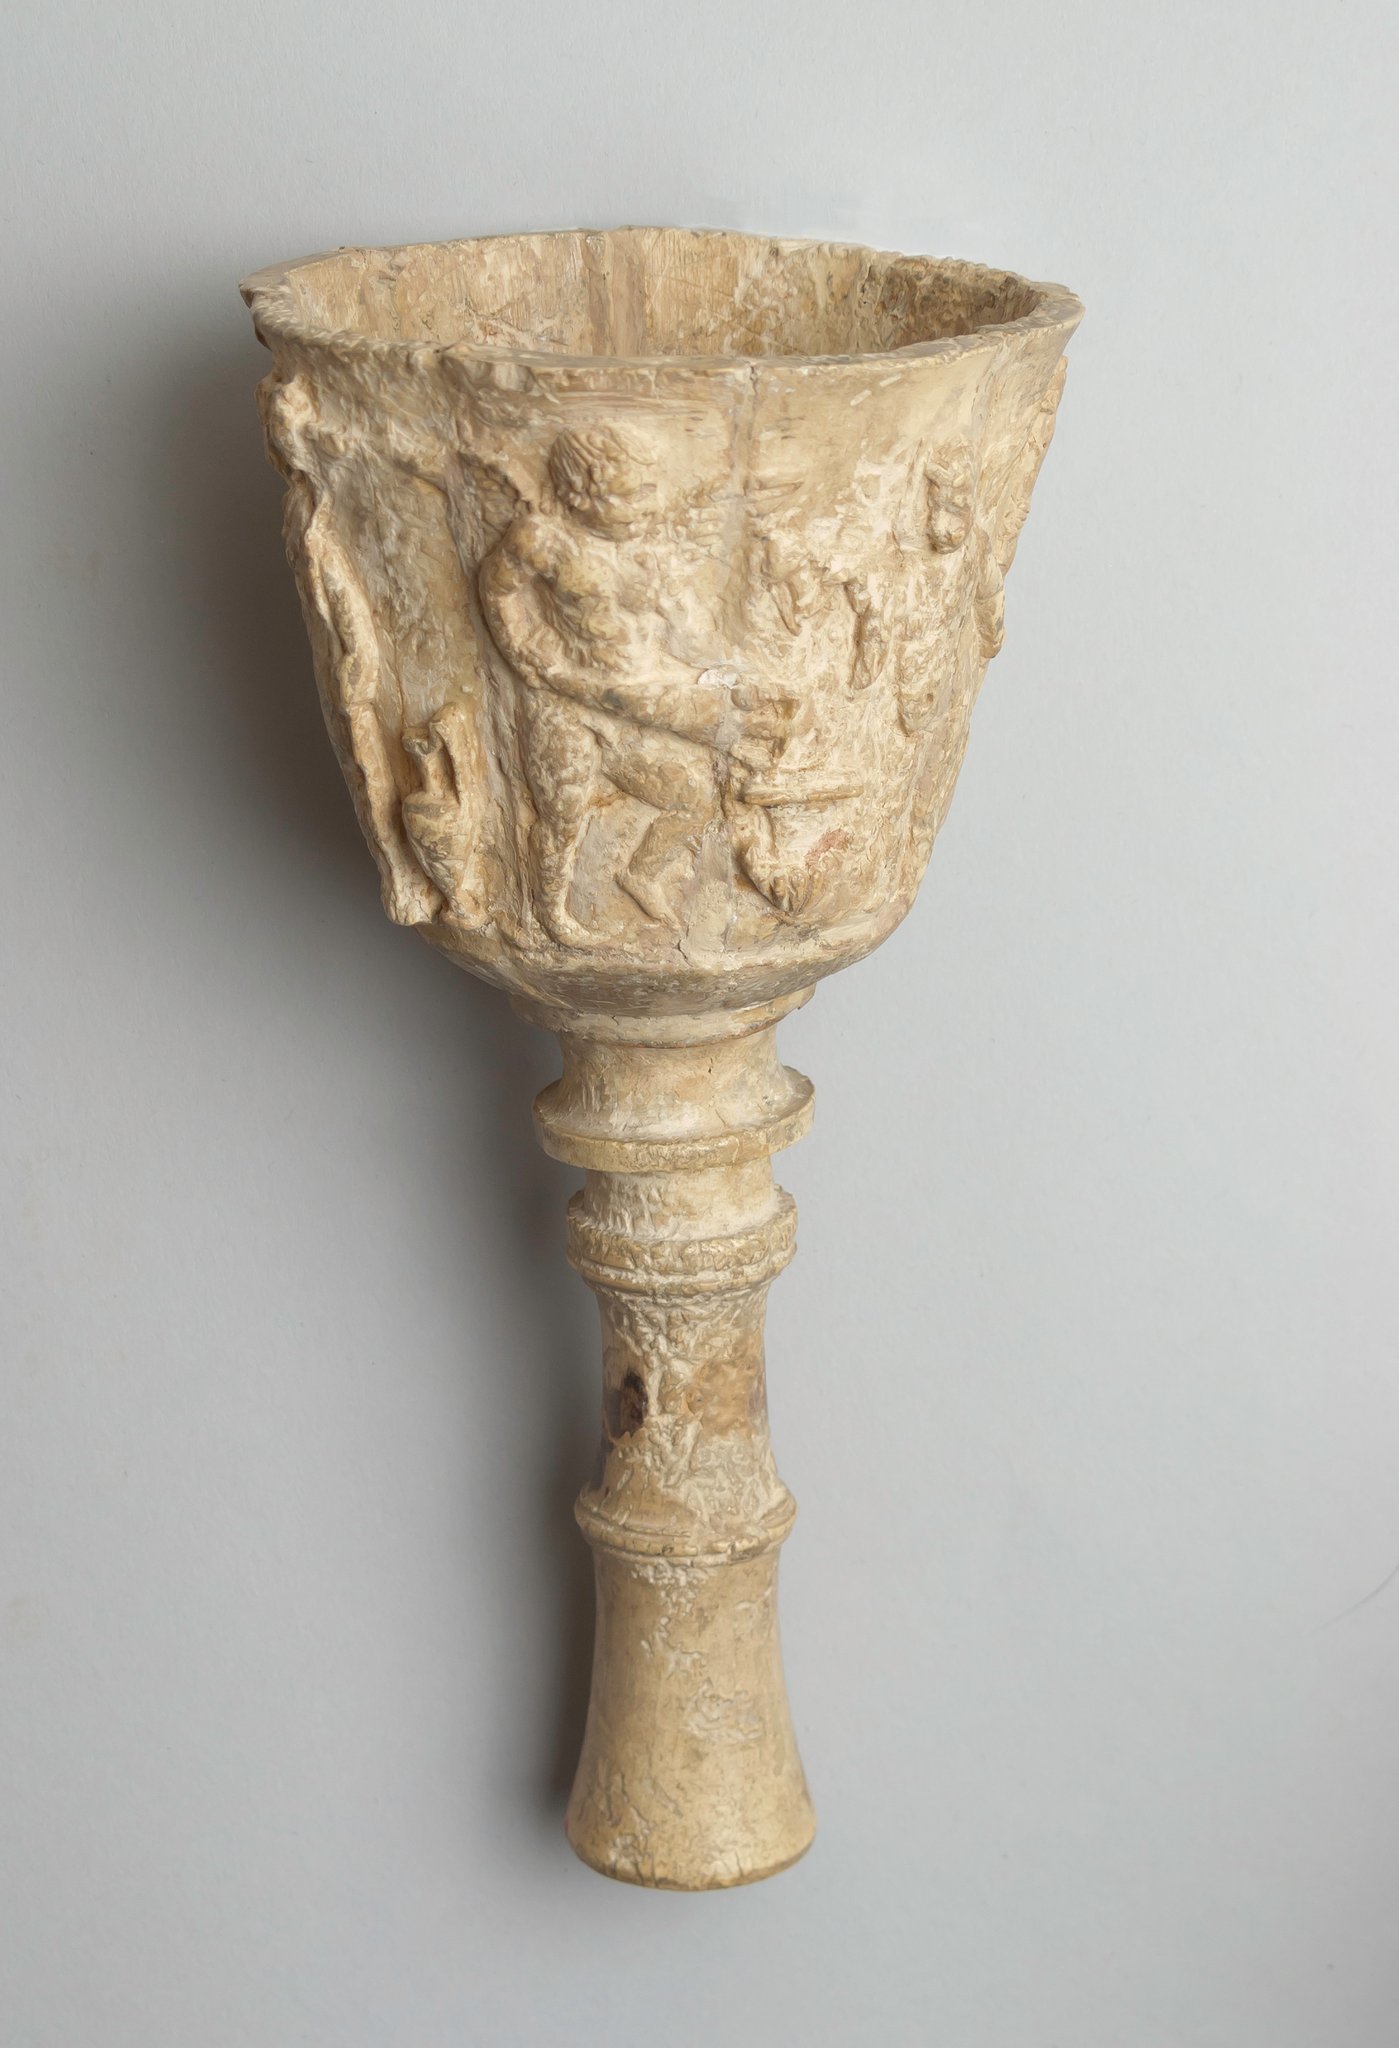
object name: cup with frieze of erotes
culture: roman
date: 1-100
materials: ivory